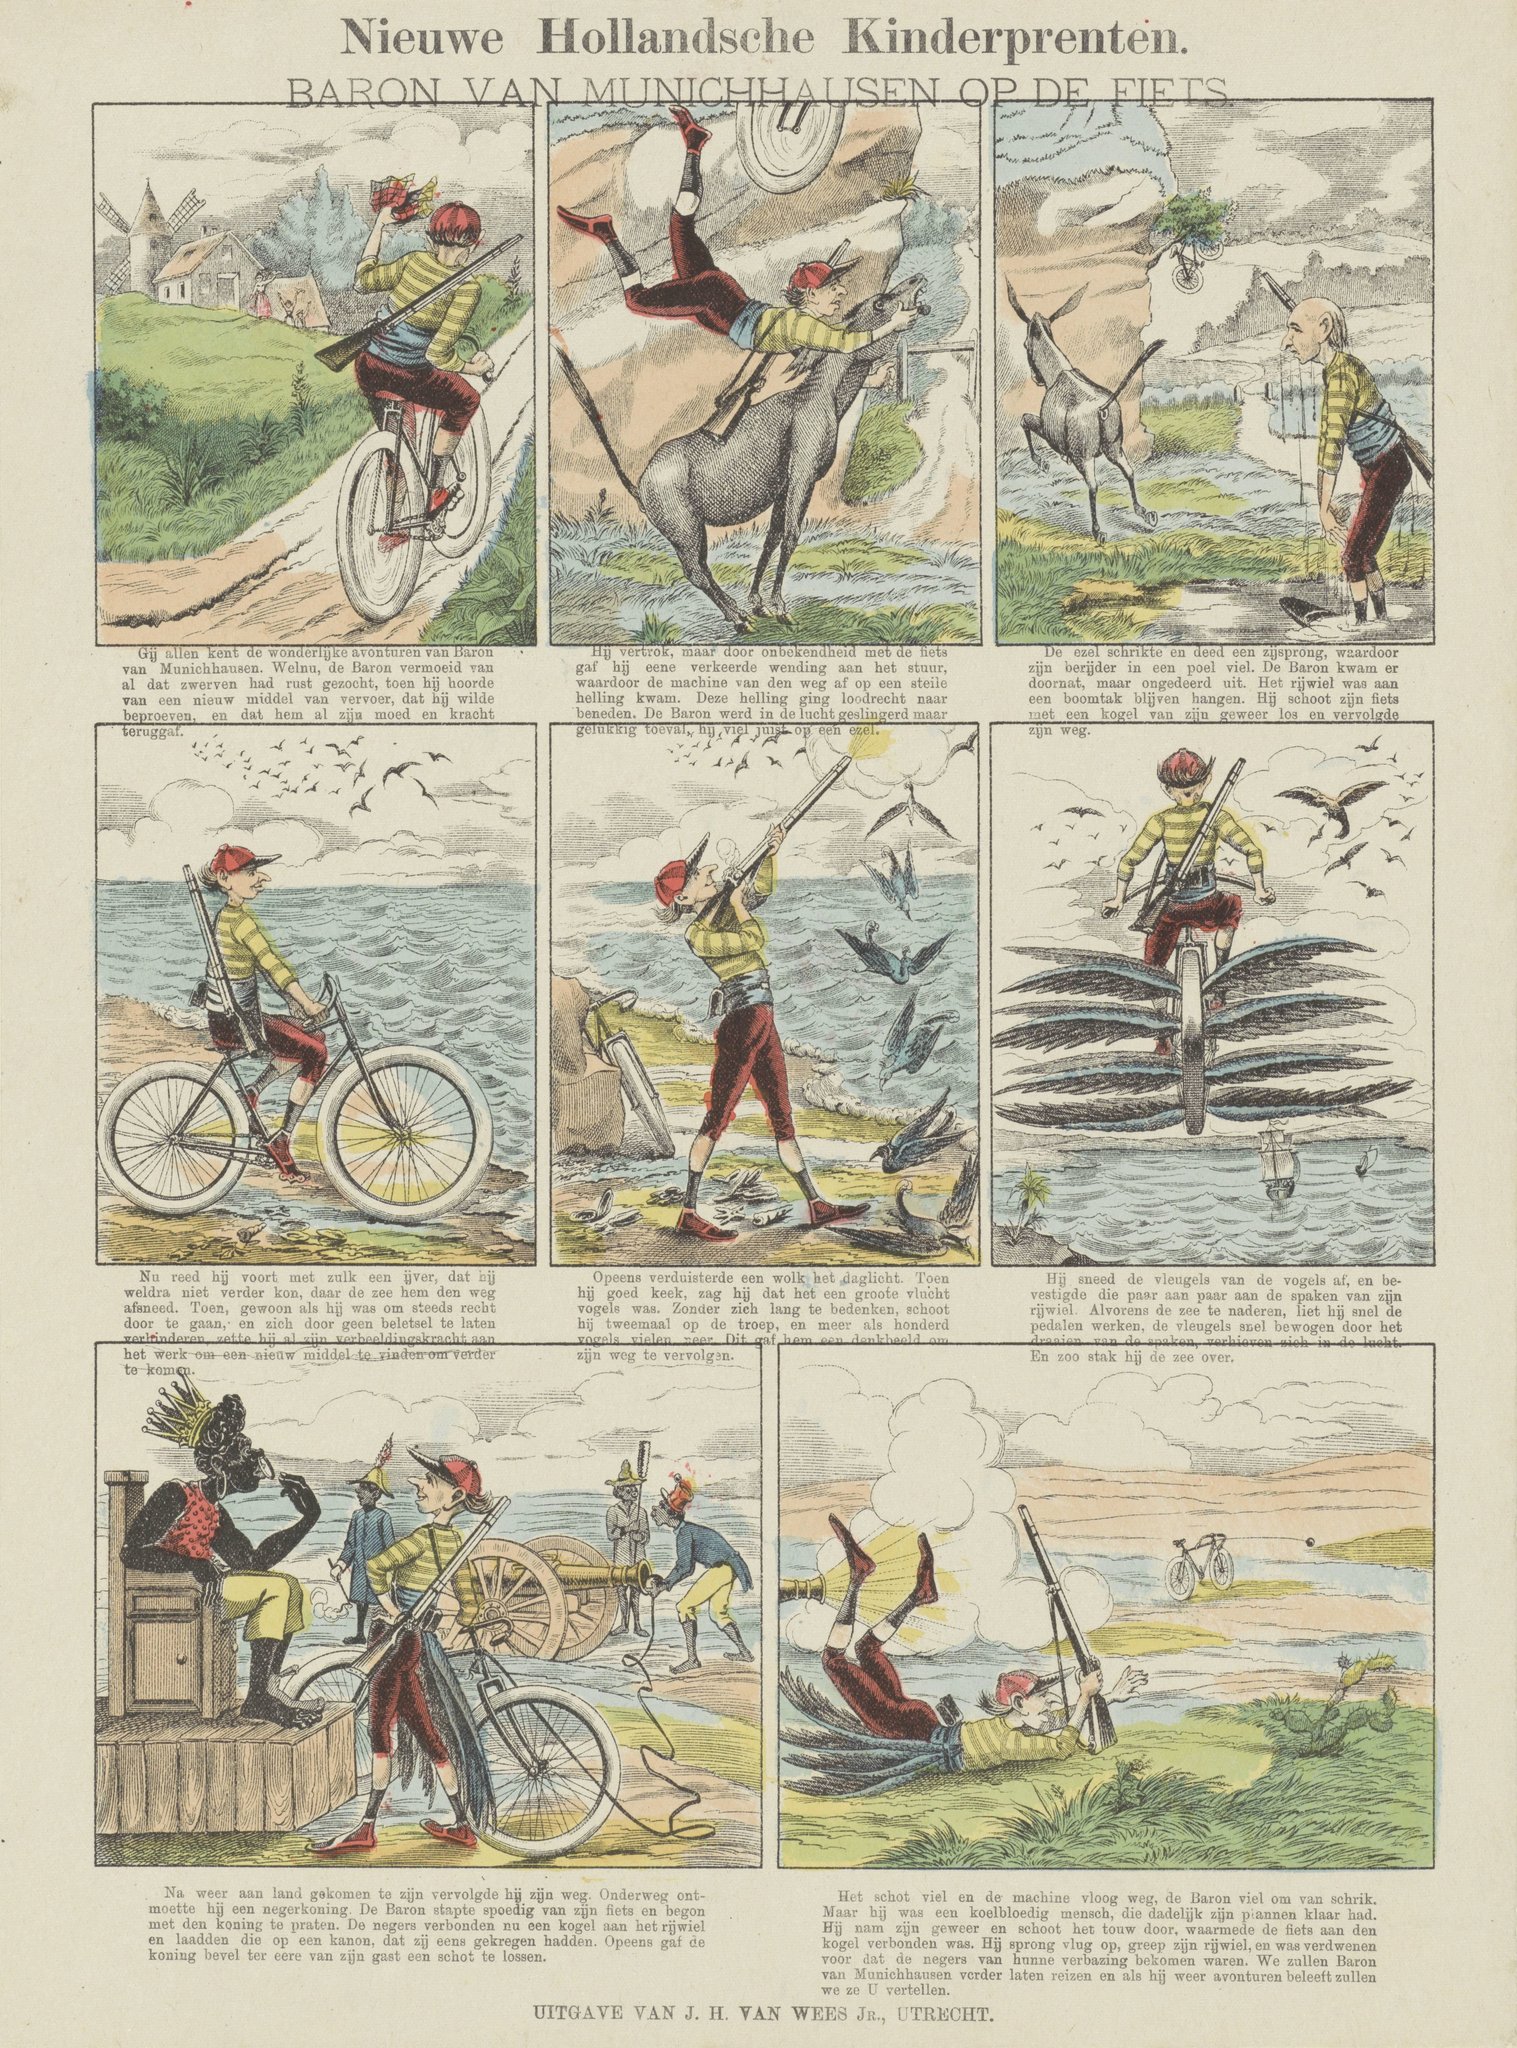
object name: print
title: Baron van Munichhausen op de fiets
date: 1869-1888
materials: paper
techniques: colour, letterpress printing, lithograph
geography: utrecht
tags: adventurer, bicycle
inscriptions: collector's mark: Lugt 2760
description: Blad met 8 voorstellingen van de sterke verhalen van baron Karl Friedrich Hieronymus von Münchhausen op de fiets. Onder elke afbeelding een onderschrift.